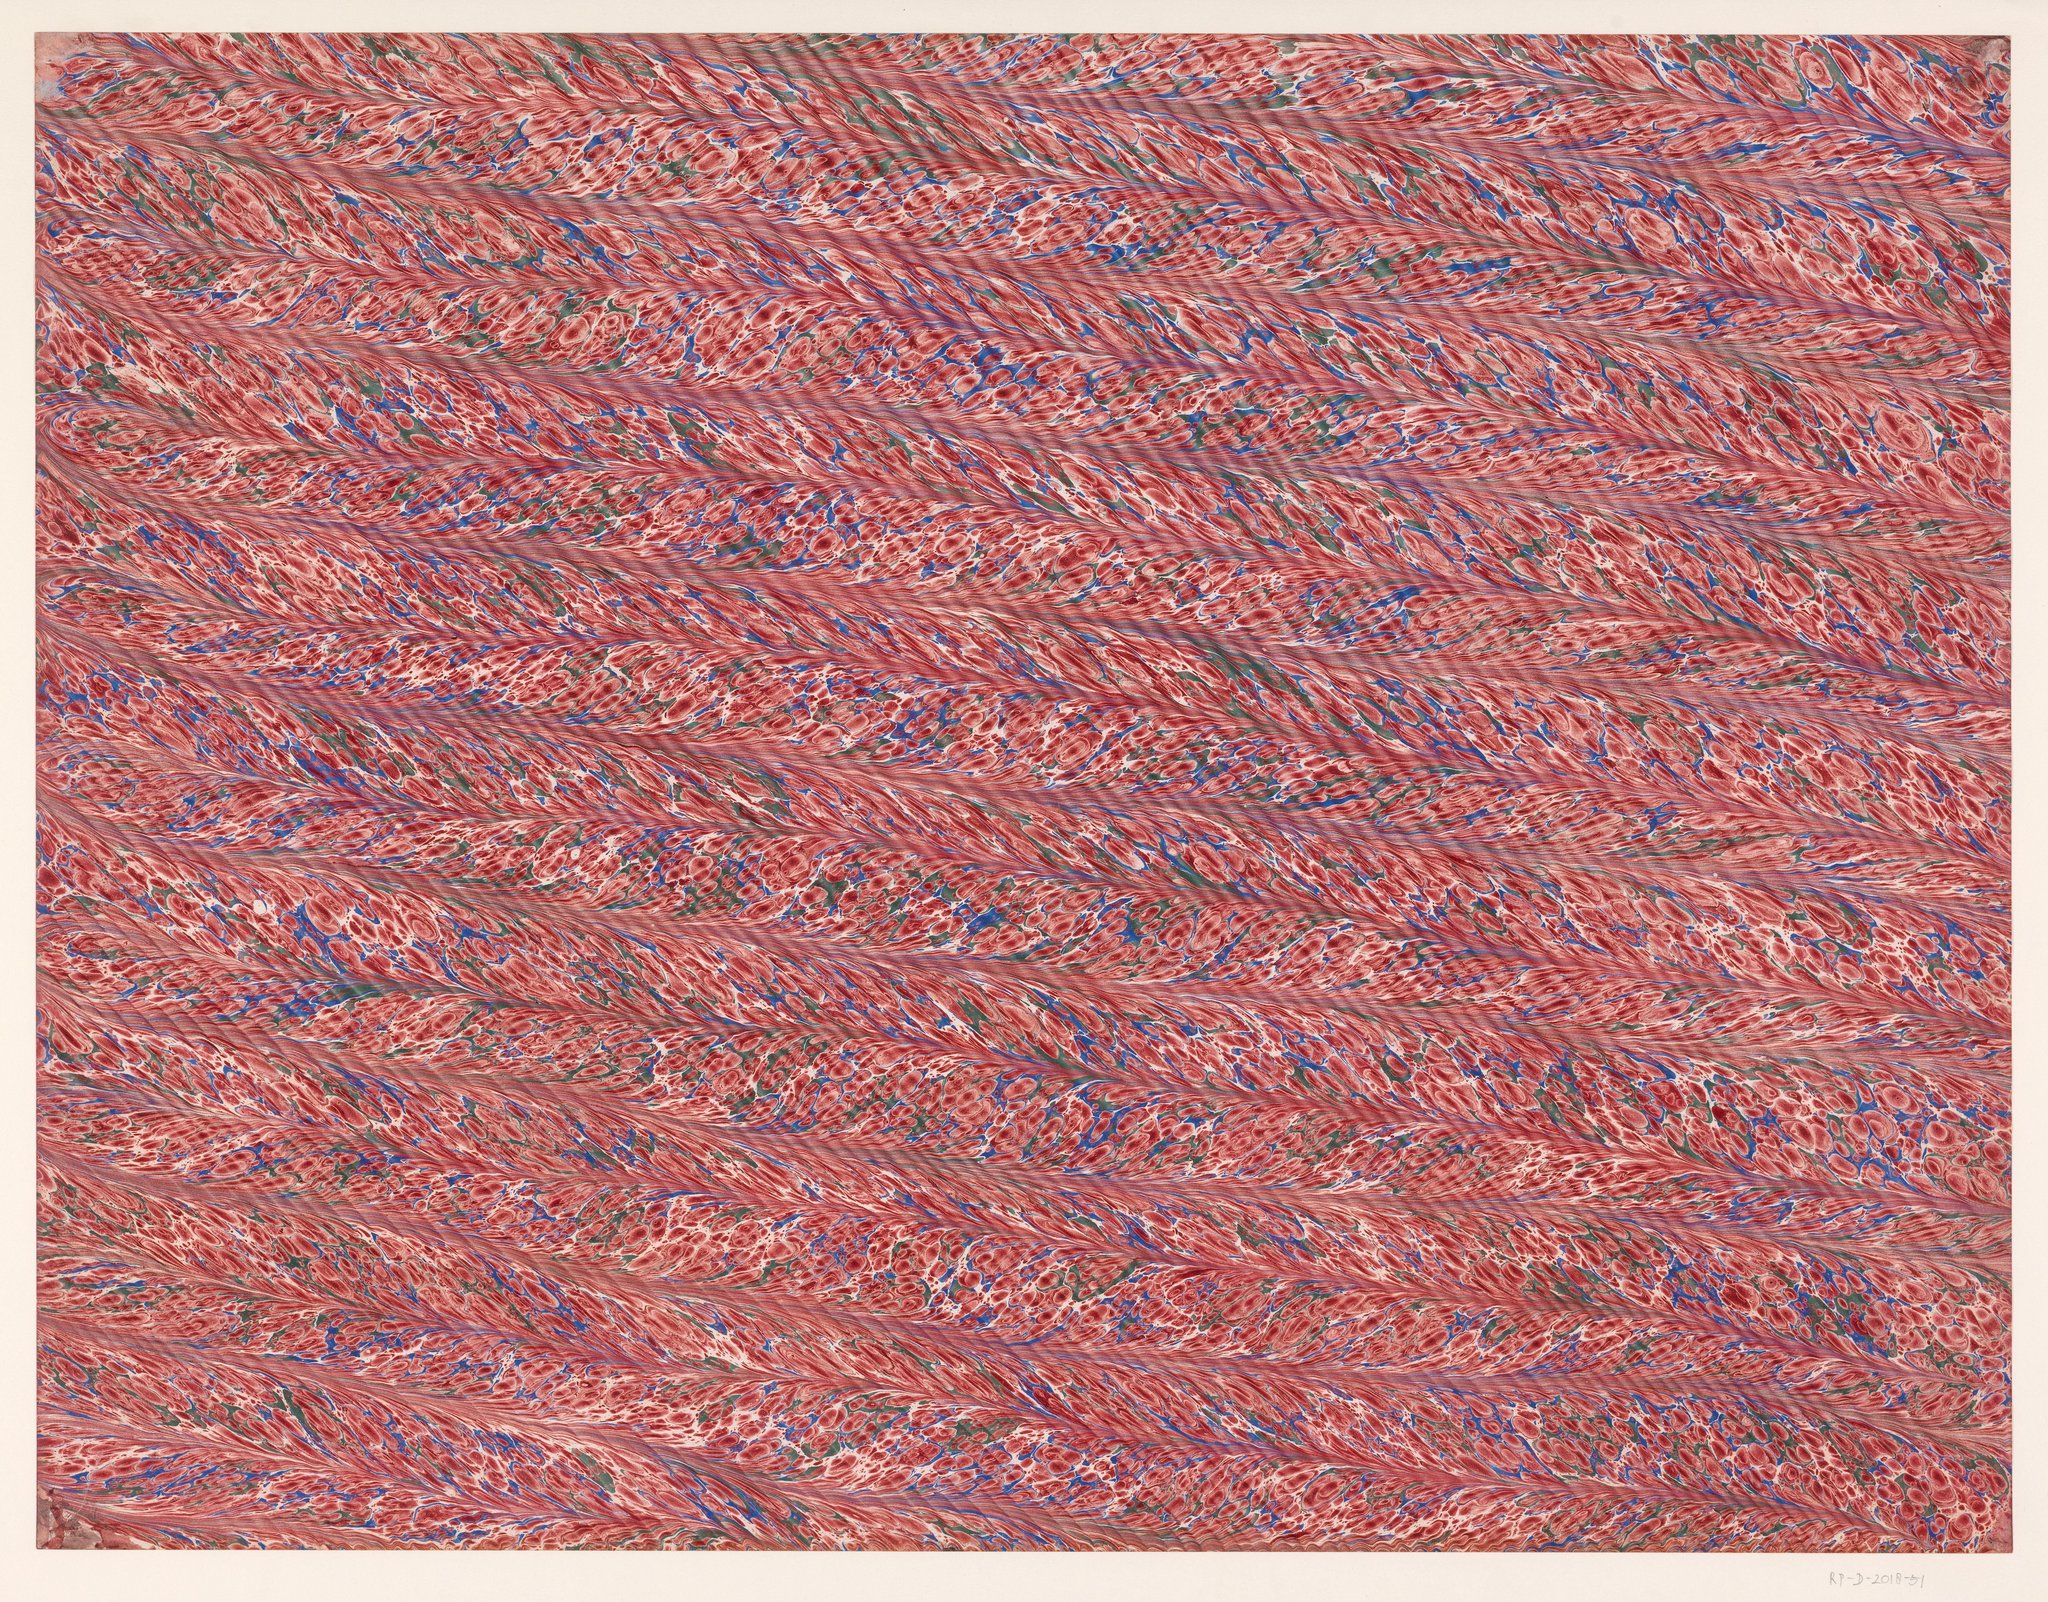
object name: marbled paper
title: Rechte-schaduwmarmer van veerkammarmer in rood, blauw en groen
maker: Anonymous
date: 1900-2000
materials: lacquer, paint, paper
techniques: marbled paper